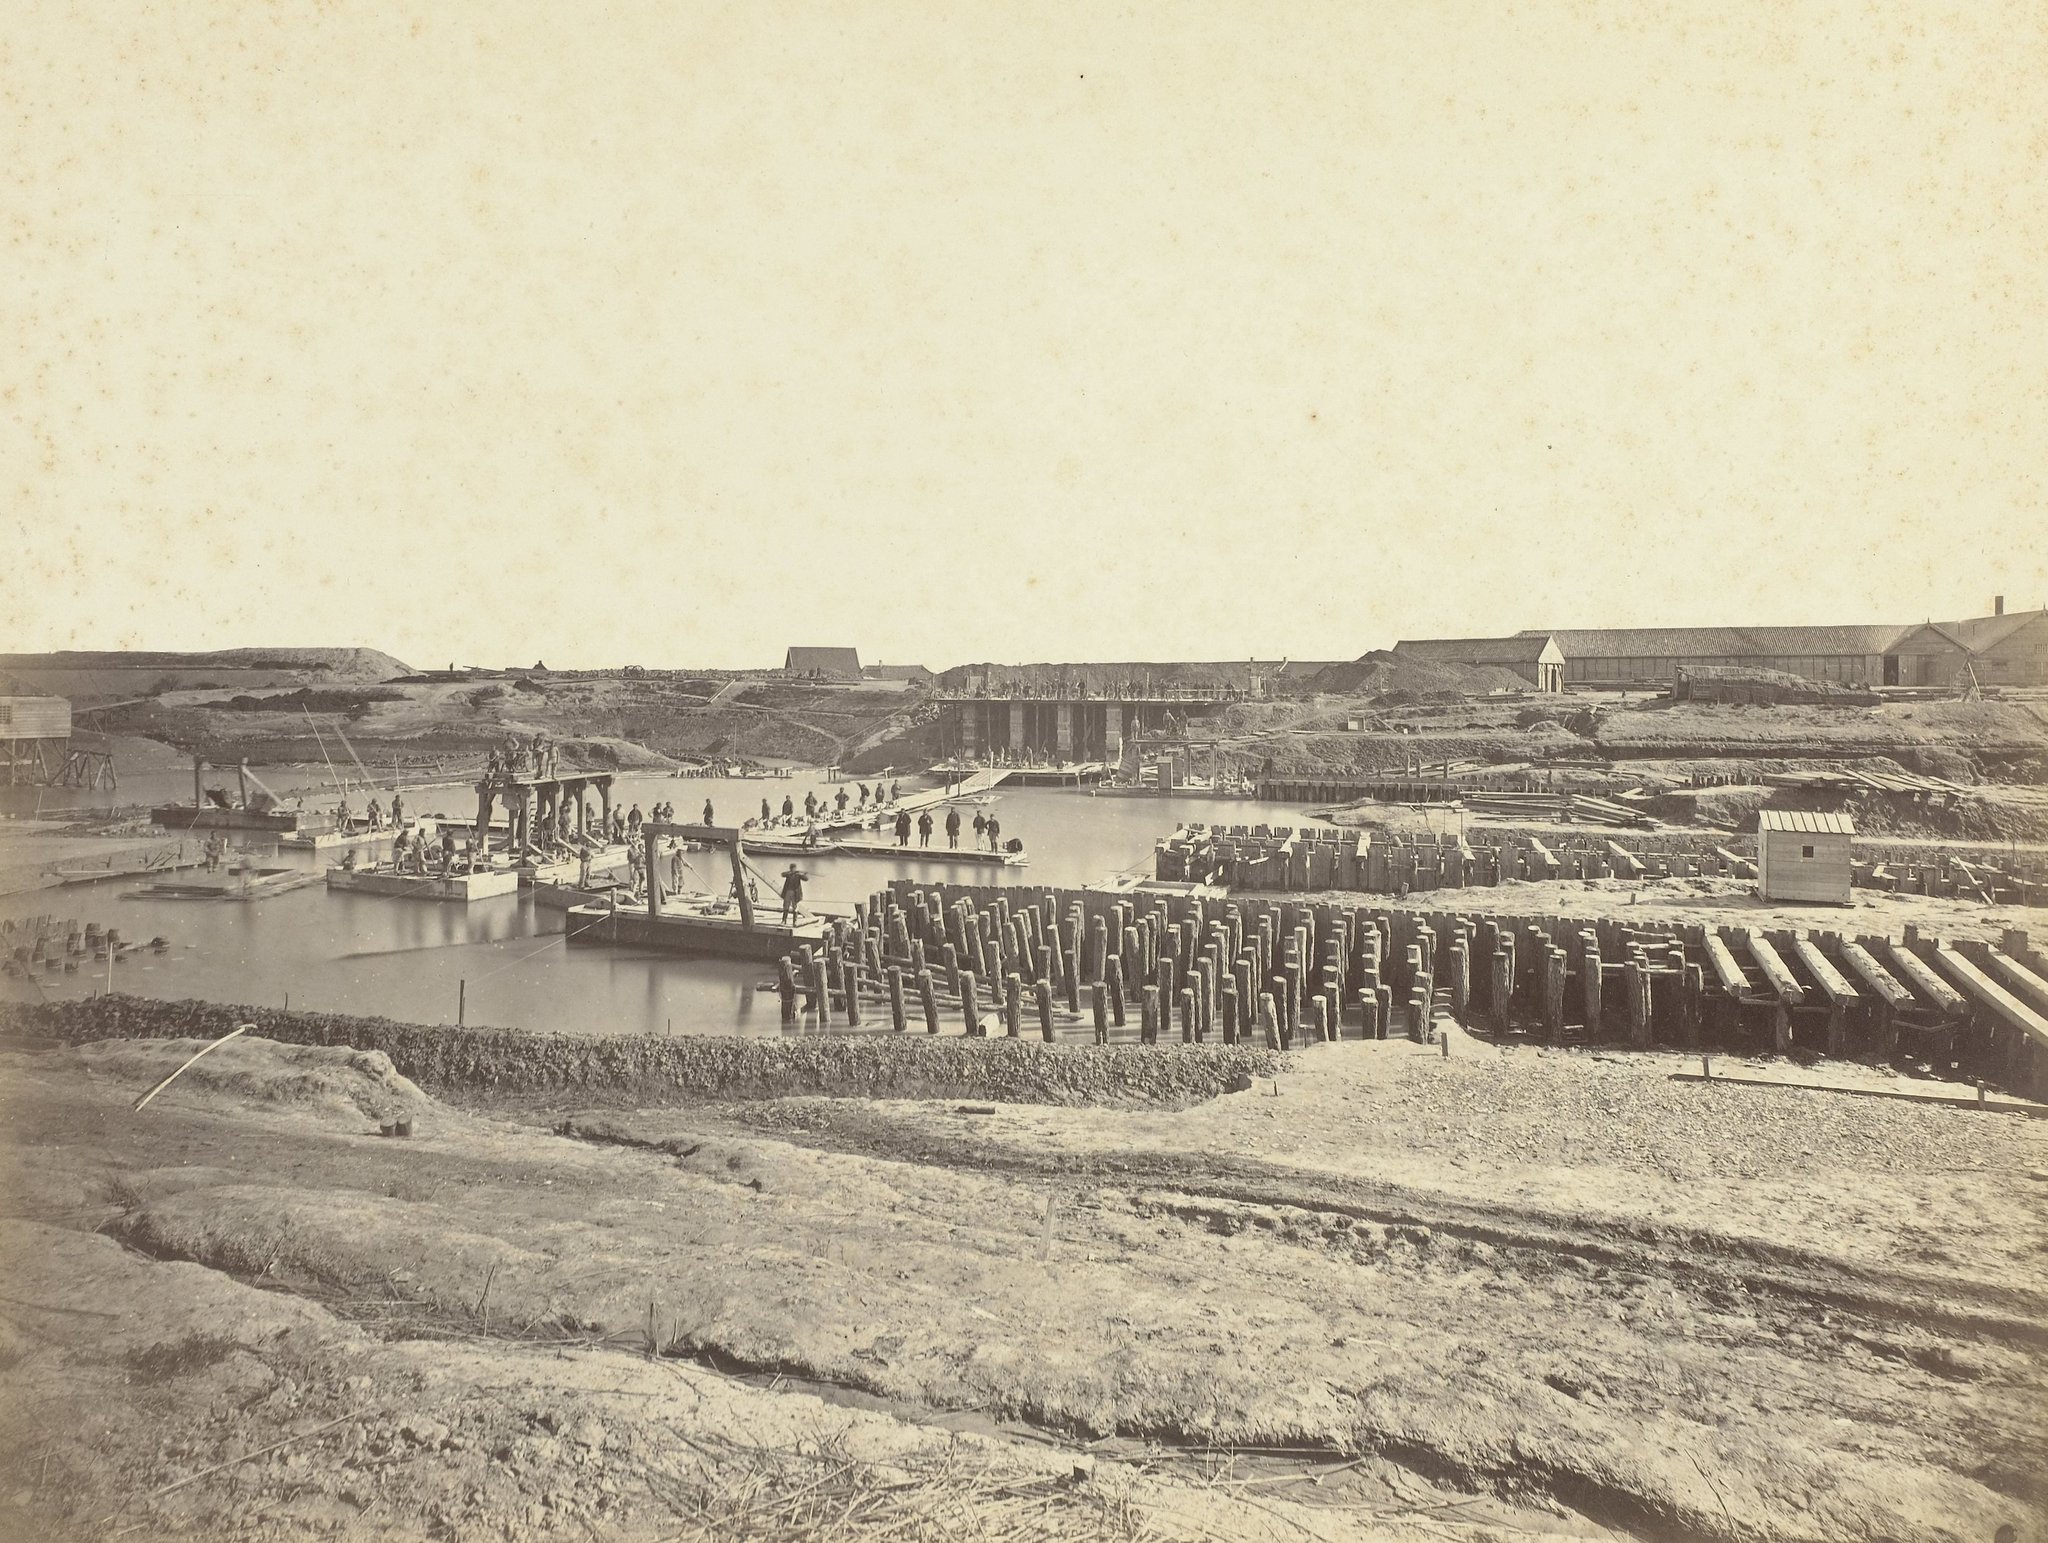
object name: photograph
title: Veere, schutsluis in aanbouw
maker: pieter oosterhuis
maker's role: draughtsman, print maker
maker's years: 1816-1885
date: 1869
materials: cardboard, paper, photographic support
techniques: albumen print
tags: weigh-house